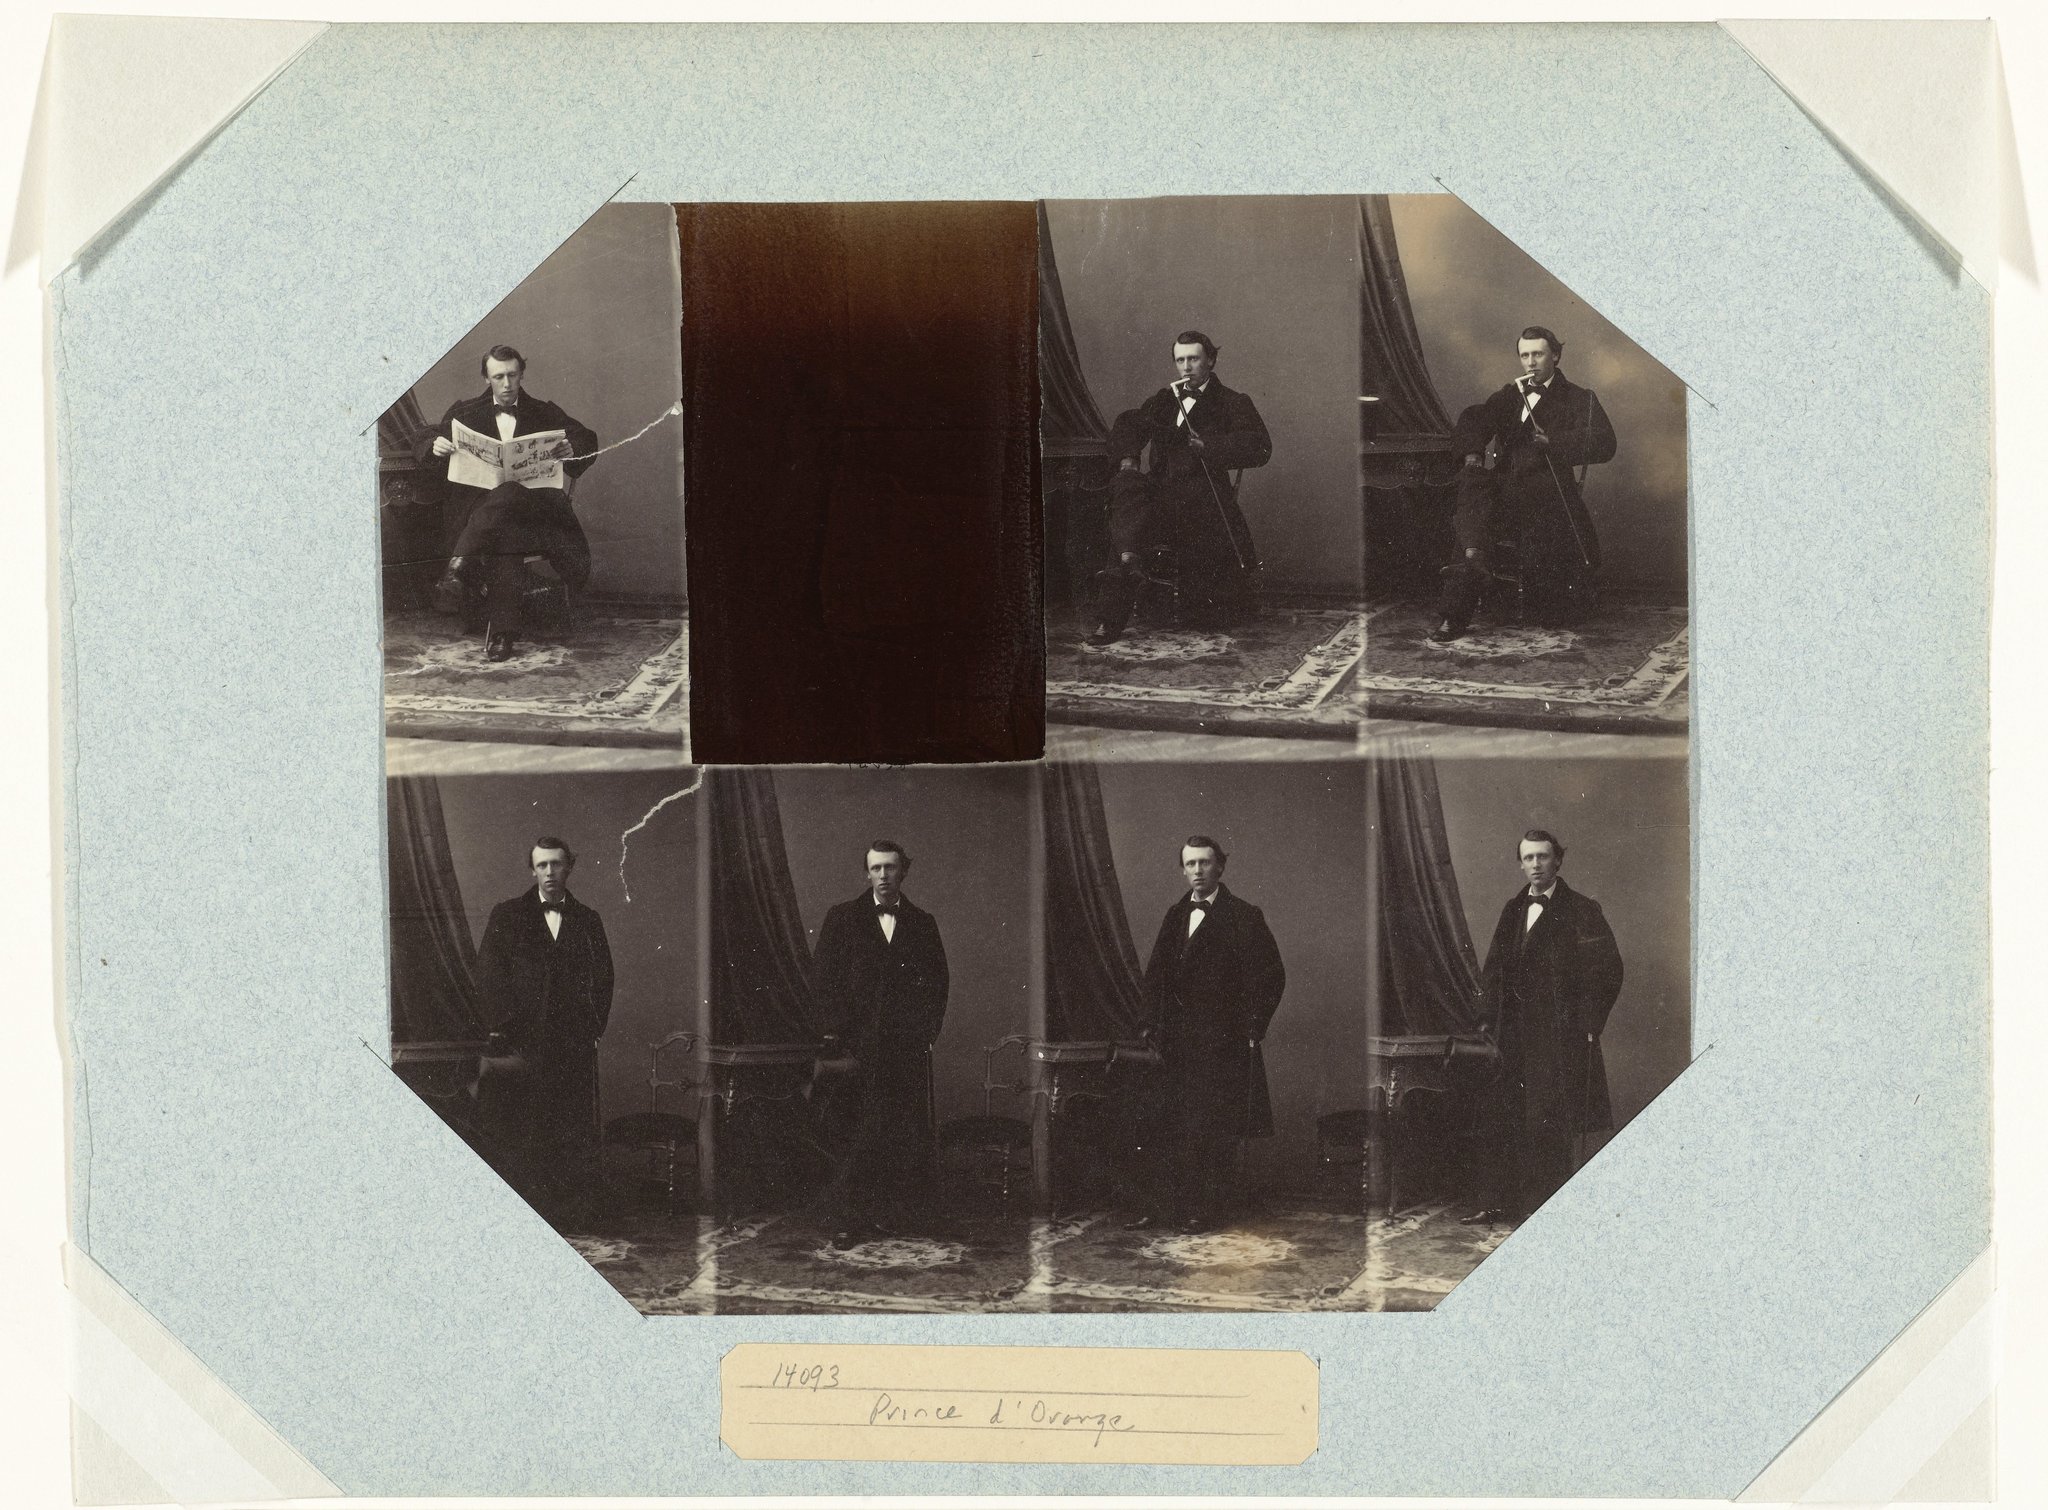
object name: carte de visite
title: Portraits of Crown Prince William of Orange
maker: andré-adolphe-eugène disdéri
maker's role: fotograaf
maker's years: 1819-1889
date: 1859-1860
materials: paper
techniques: albumen print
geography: paris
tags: the hague, paris, willem (prins der nederlanden), adult man, historical persons, crown prince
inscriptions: inscription: ‘14093/ Prince d'Orange’, number: ‘14093’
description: In 1859 the Dutch crown prince William of Orange visited Disdéri’s famous photography studio in Paris. The latter had devised the idea of selling small visitingcard format pictures of famous people. He had a camera specially built with which he could capture eight poses on a single negative, in William’s case he took two shots. Dealers and private individuals could order photographs from the contact sheets.